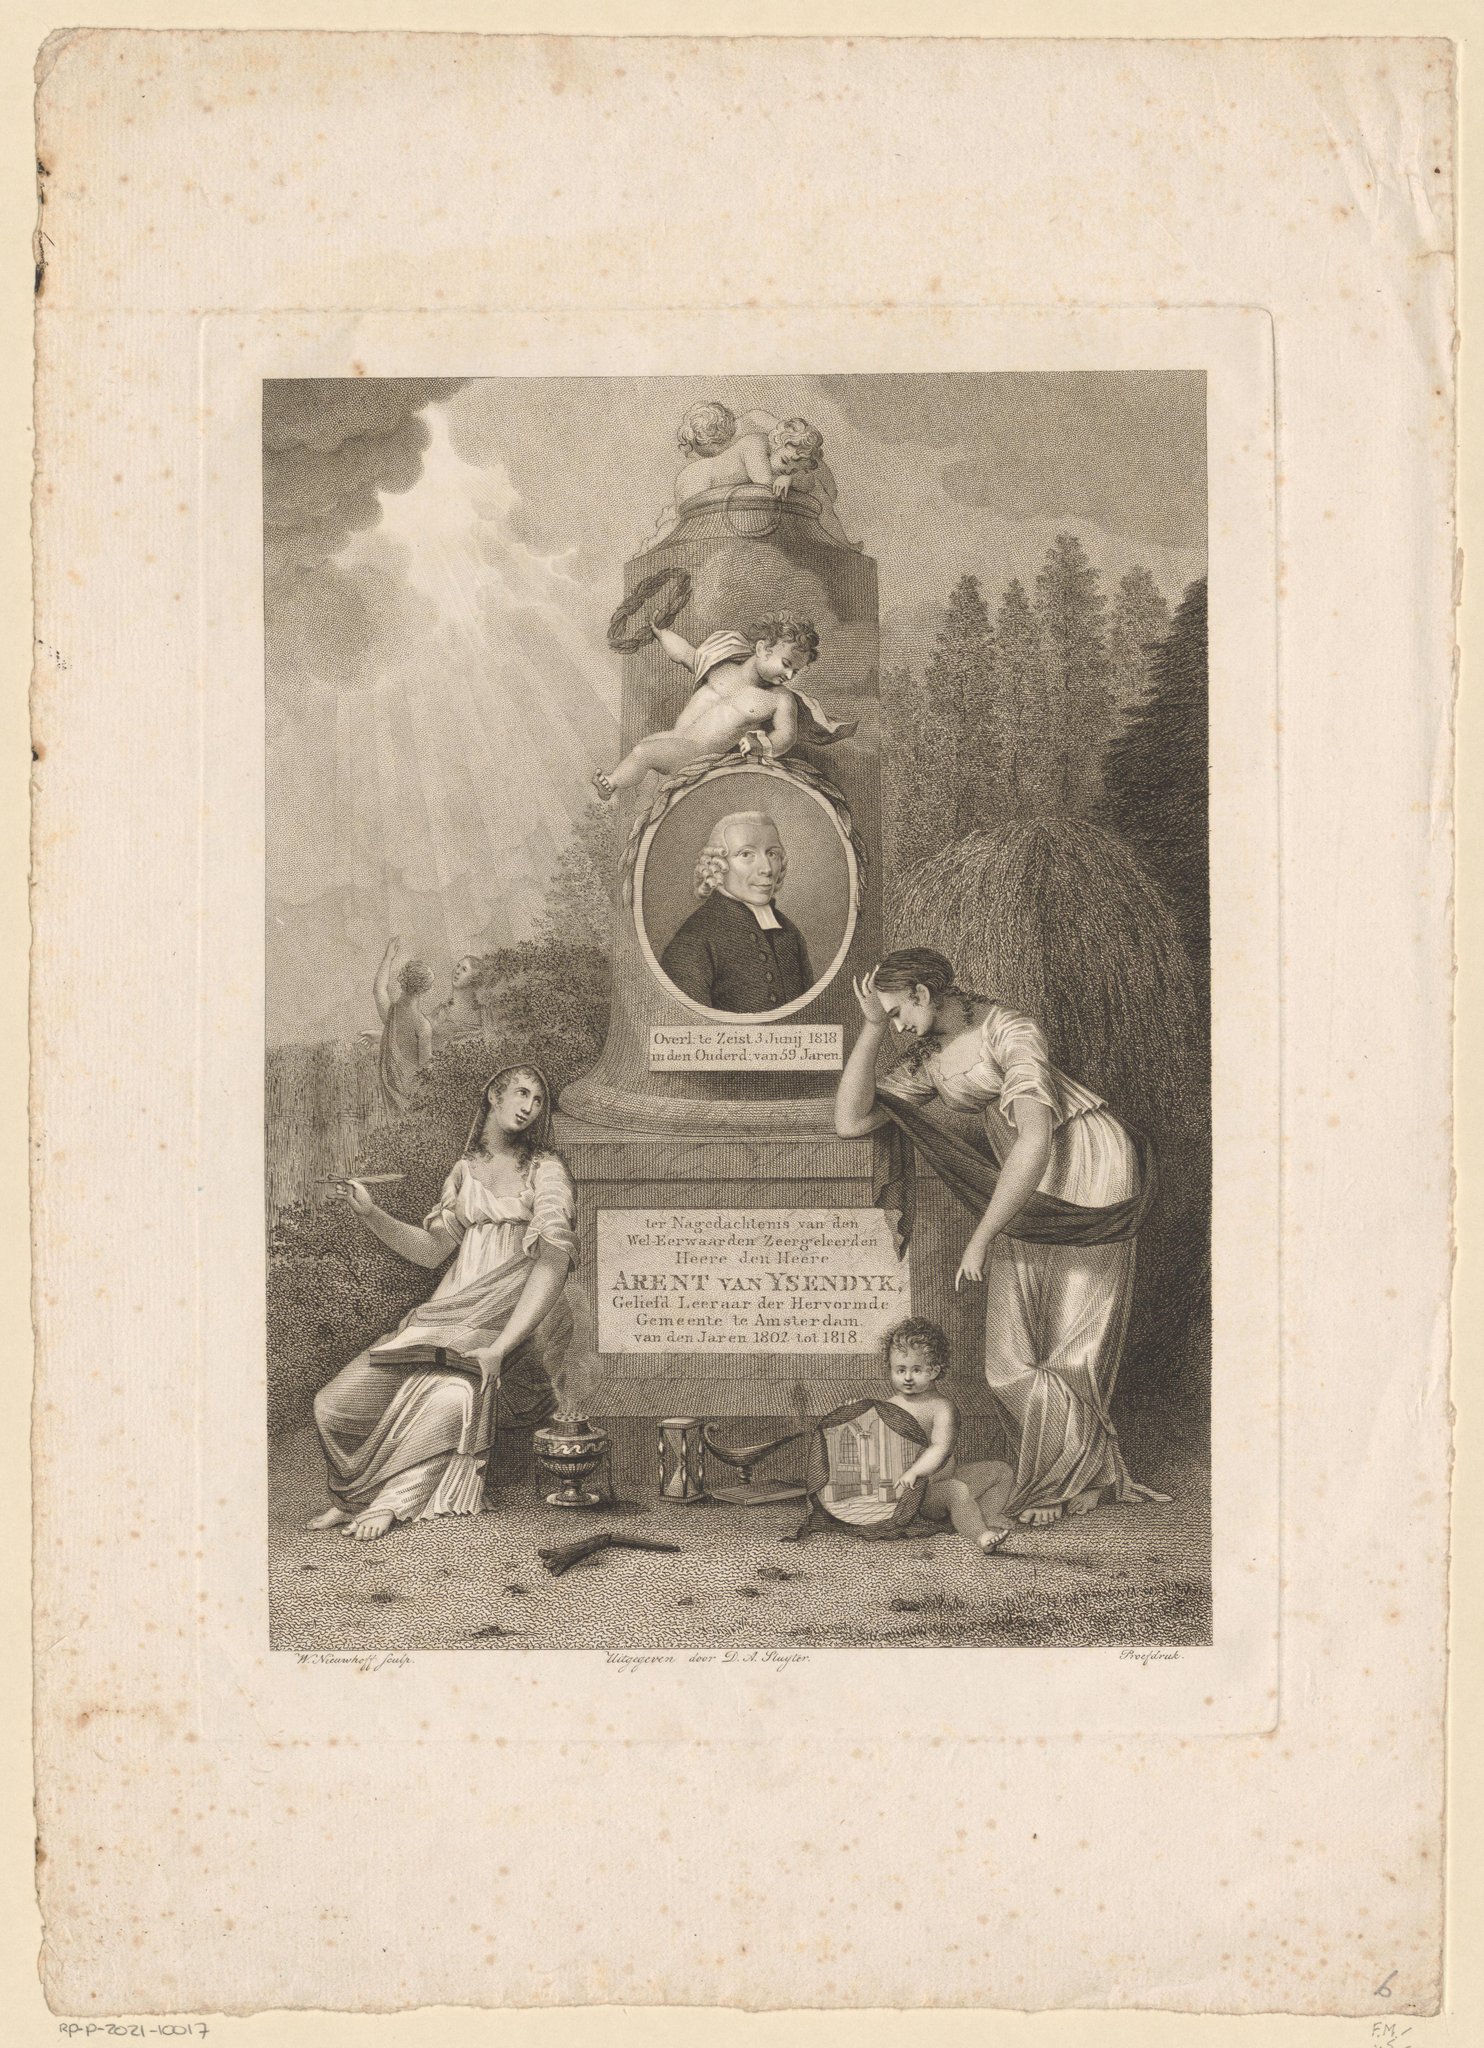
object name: print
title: Gedenkteken voor Arent van Ysendyck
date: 1818-1820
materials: paper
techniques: engraving, etching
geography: the hague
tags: zeist, symbols of last judgement, torch (+ extinguishing; extinguished light, lamp, candle), faith, 'fides'; 'fede', 'fede catholica', 'fede christiana', 'fede christiana catholica' (ripa) ~ one of the three theological virtues, historical persons, the sower ~ parable of christ (matthew 13:3-9; mark 4:3-9; luke 8:5-8), hourglass, mourning the dead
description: Een gedenkteken voor Arent van Ysendyck, predikant te Amsterdam, die in 1818 overleed. Op de zuil is het portret van Van Ysendyck aangebracht en de basis toont een plaquette met een zevenregelige tekst in het Nederlands. Het monument wordt geflankeerd door het Geloof met een boek op haar schoot en in haar hand een schrijfveer en door de treurende Godsdienst. Een putto toont de beeltenis van een kerkinterieur. Op de grond liggen de gedoofde en gebroken toorts en een zandloper ten teken van de dood. Links op de achtergrond staan twee figuren tussen korenschoven, waarvan één omhoog wijst naar het zonlicht. De bijeengebonden schoven duiden op het Laatste Oordeel, waarbij God het zaad of zijn Woord dat in goede grond is gevallen, naar de gelijkenis van de zaaier, zal oogsten.